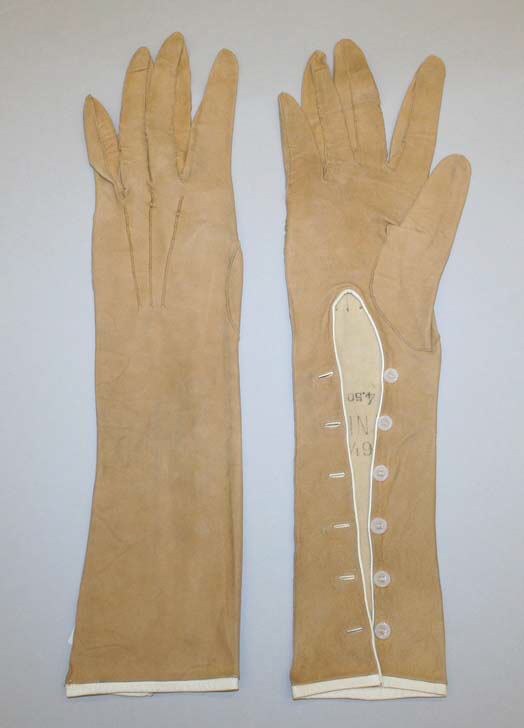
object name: glove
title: Gloves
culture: french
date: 1871